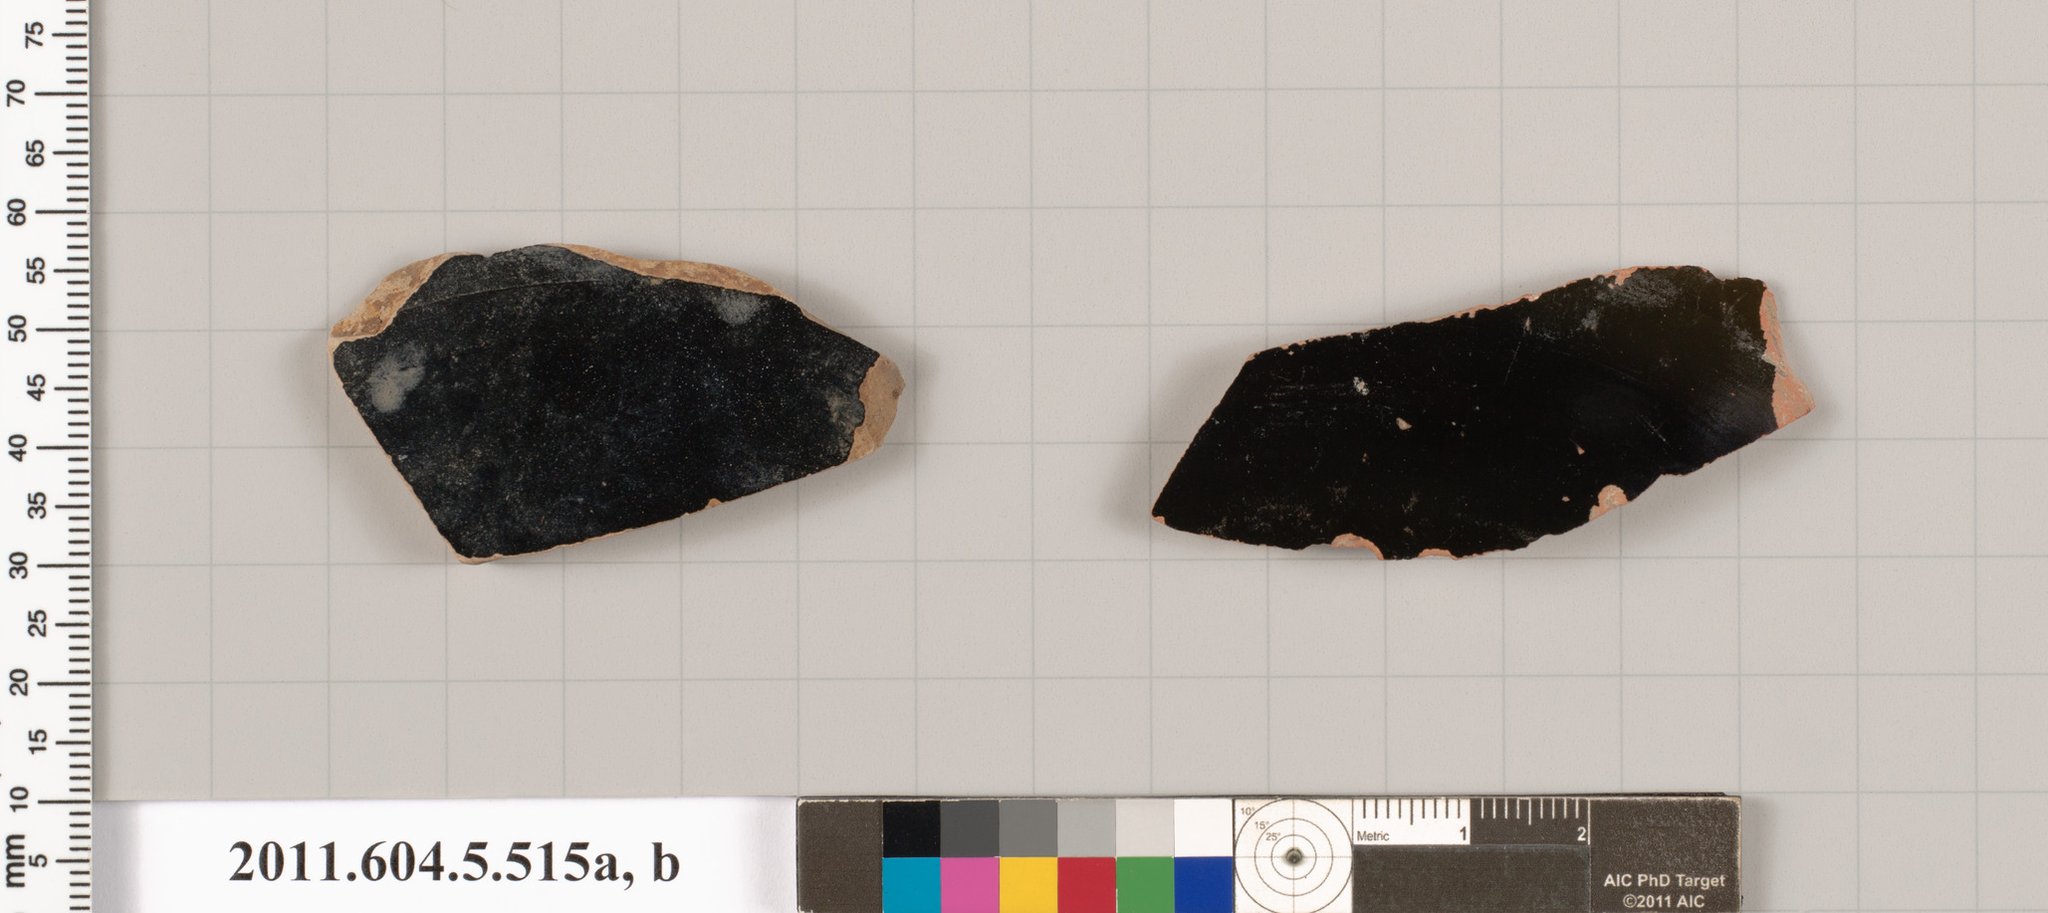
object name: kylix fragment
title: Terracotta fragments of kylikes (drinking cups)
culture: greek, attic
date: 600-401 BCE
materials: terracotta